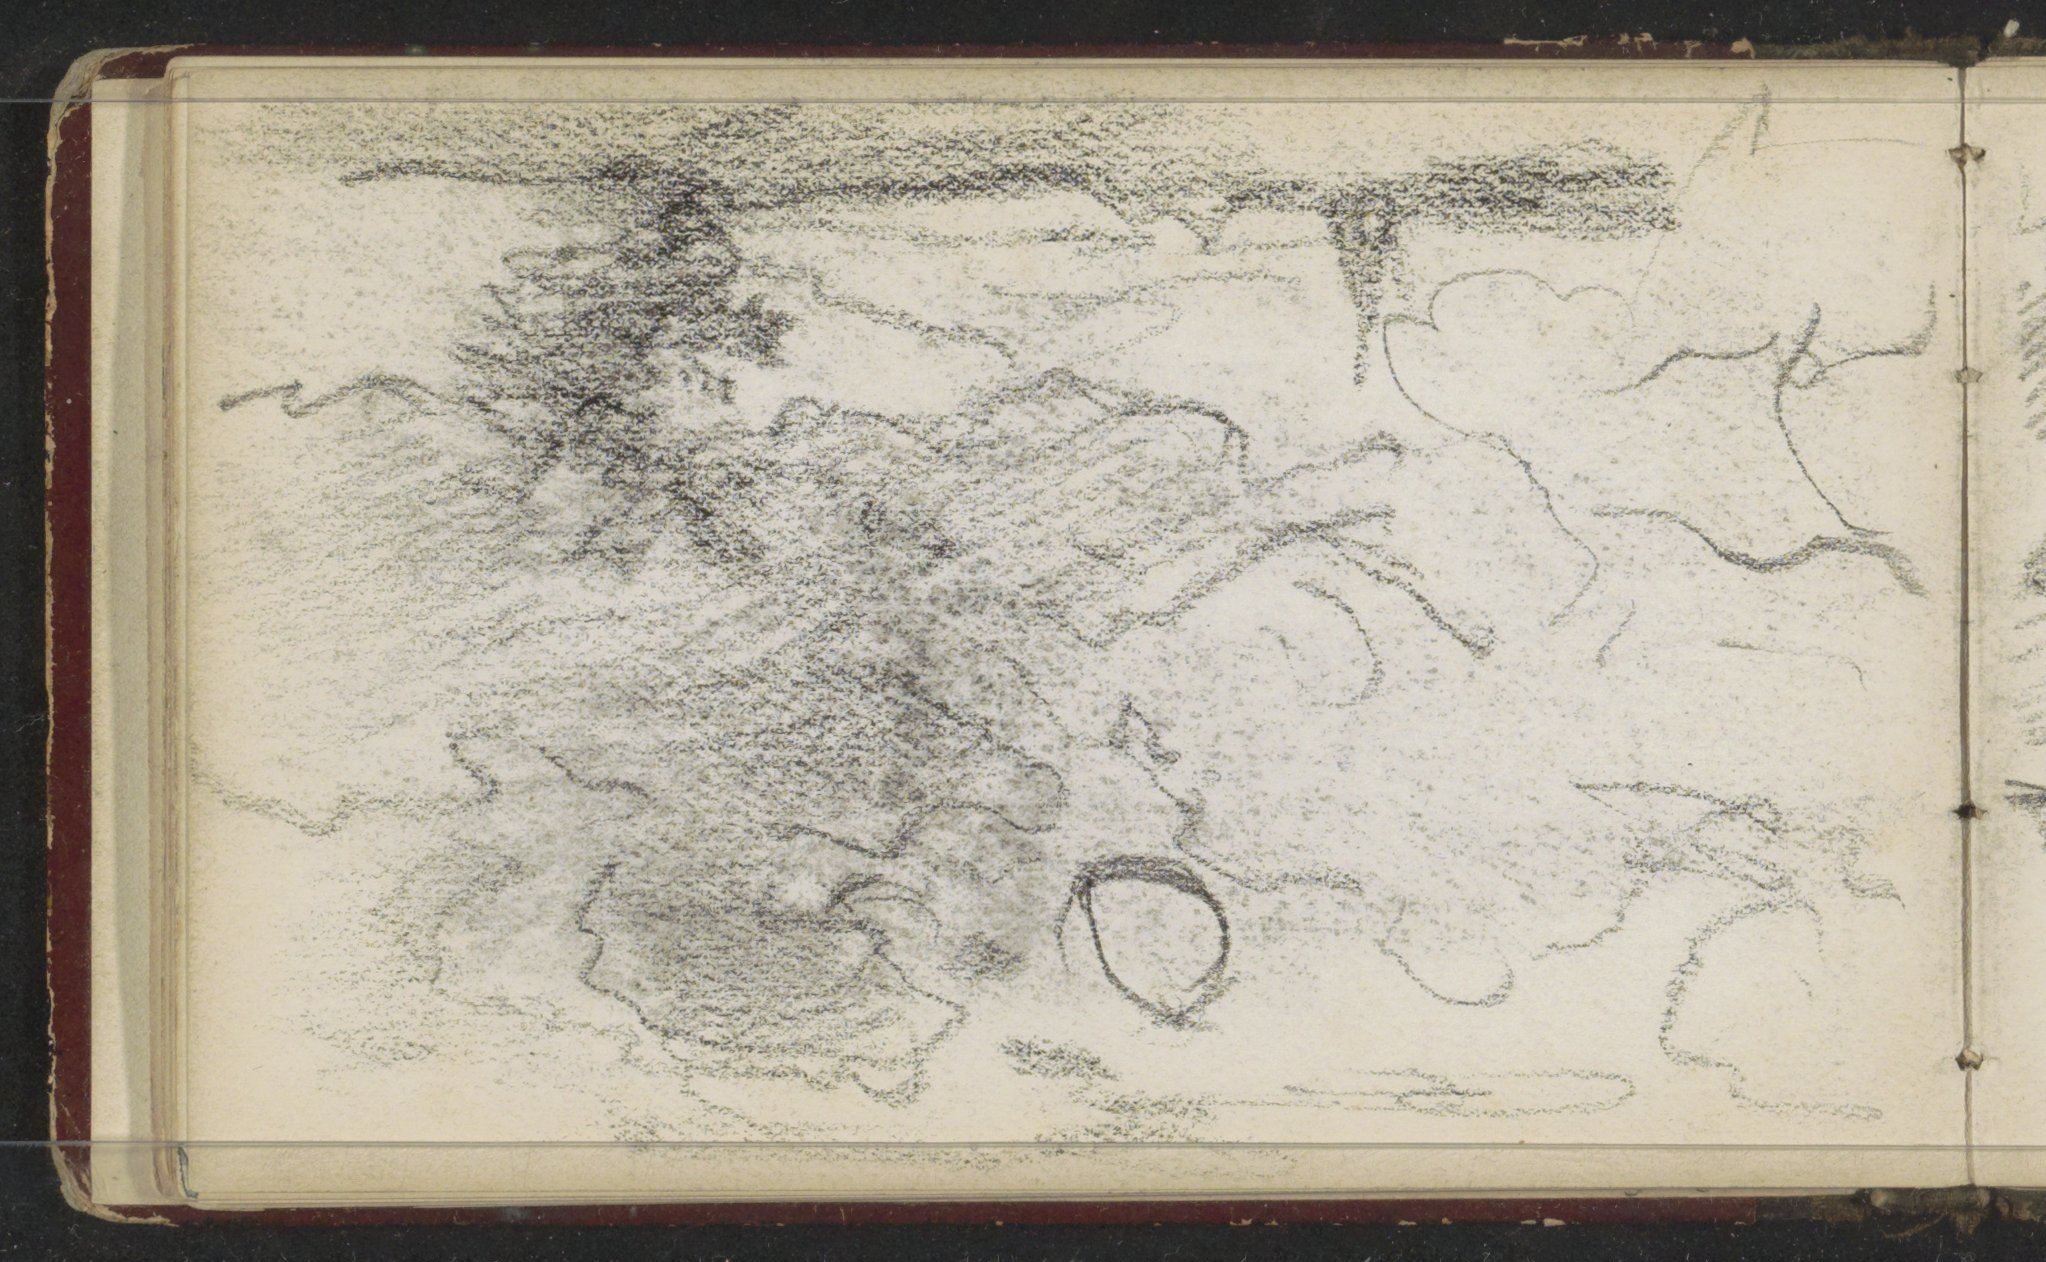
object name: sketchbook leaf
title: Wolkenlucht boven een landschap met molen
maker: willem cornelis rip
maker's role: draughtsman, painter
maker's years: 1856-1922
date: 1891-1892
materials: chalk, paper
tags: clouds, windmill in landscape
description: Blad 15 verso uit een schetsboek met 28 bladen.